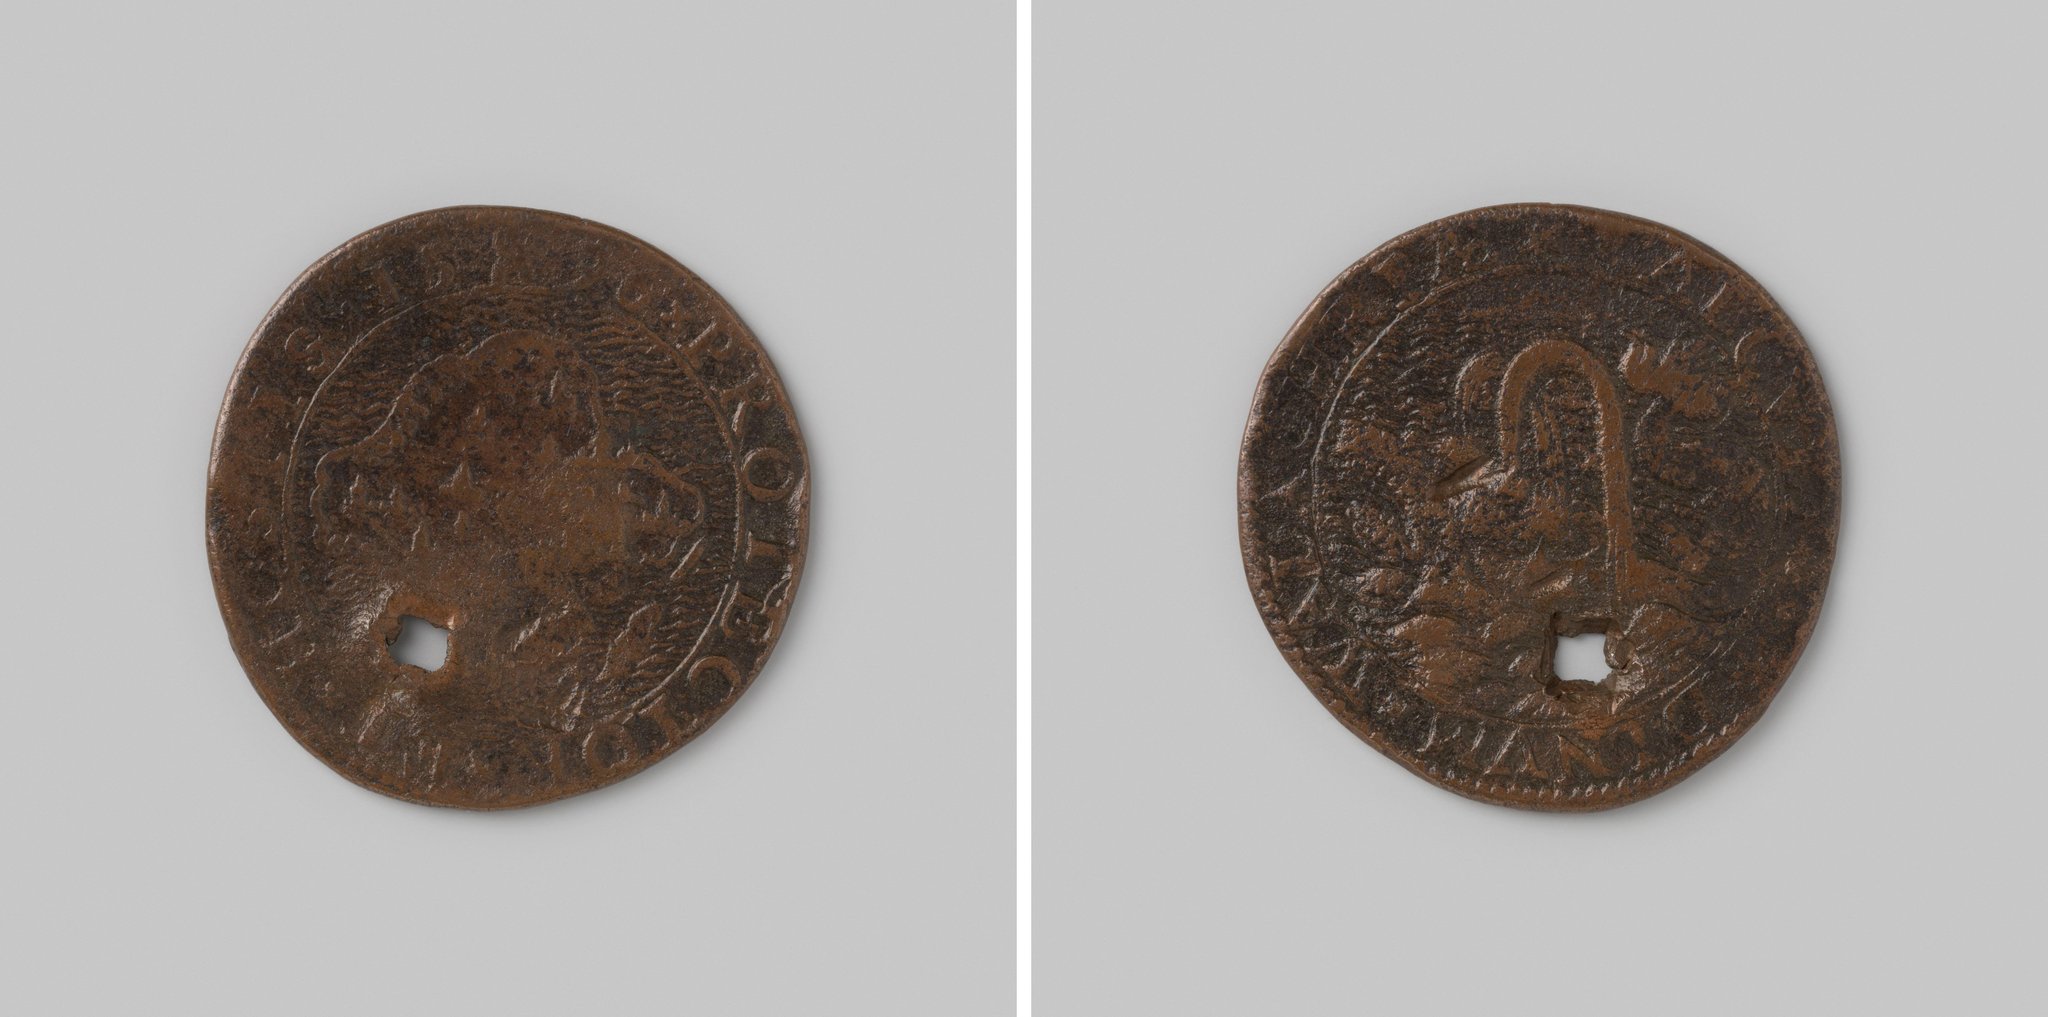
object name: jeton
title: Rekenpenning uit Middelburg voor de Staten van Wacheren op het vergaan van de Spaanse Vloot bij Kaap Finsteren 1596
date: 1596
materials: copper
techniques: striking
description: Koperen penning met spijkergat, op de voorzijde het eiland Walcheren, met omschrift, op de keerzijde een walvis, met omschrift.